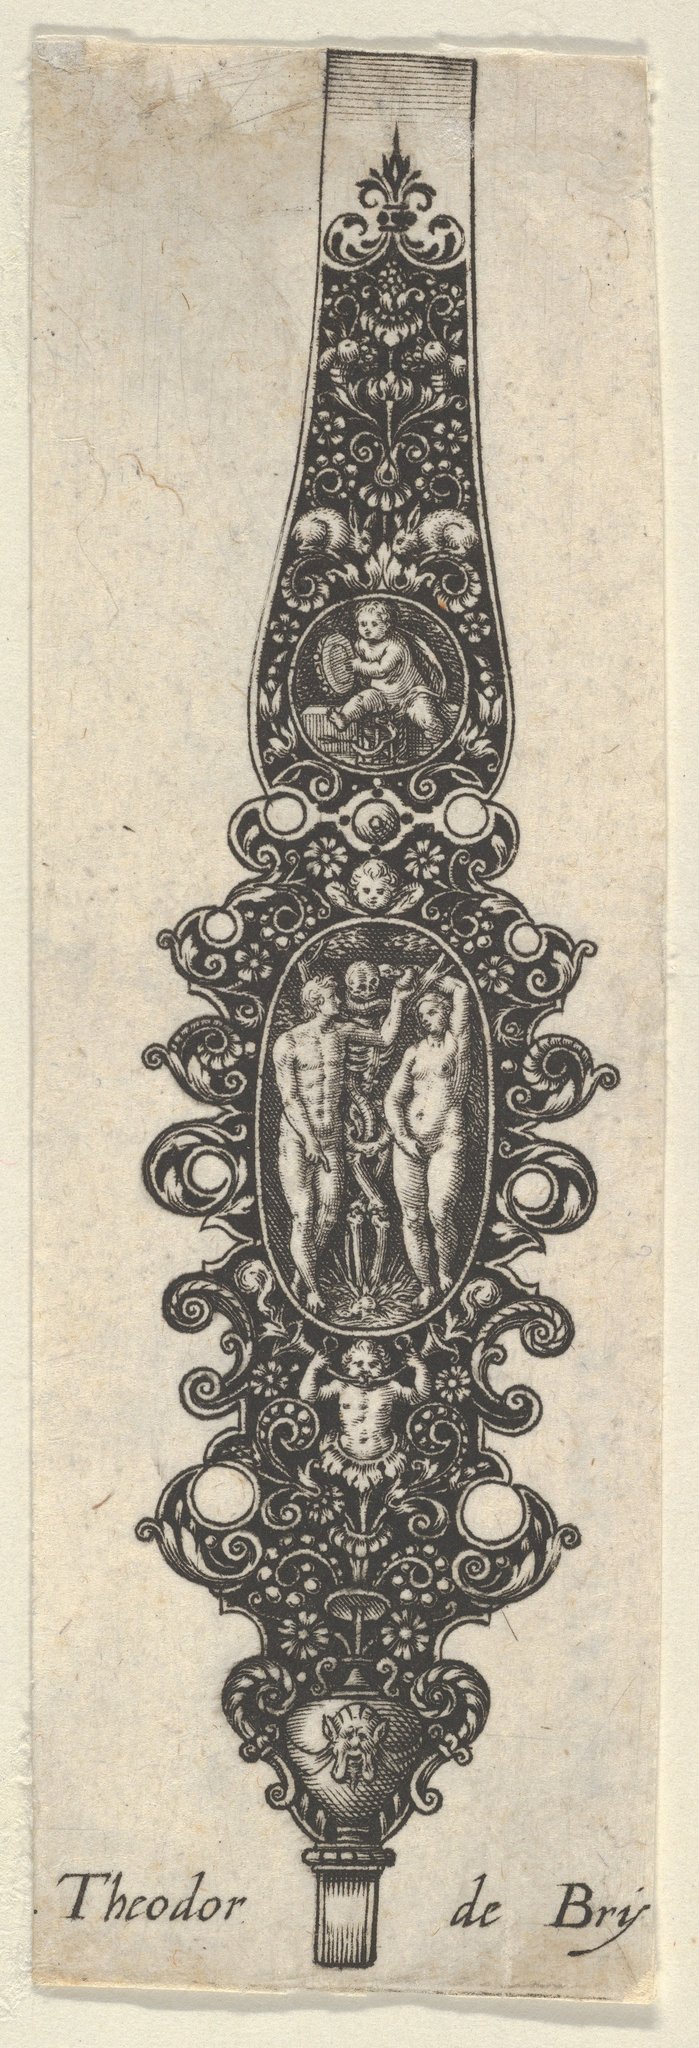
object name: print ornament architecture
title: Pendant Design with Adam and Eve, from Des Pendants de Cleffs pour les Femmes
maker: johann theodor de bry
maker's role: artist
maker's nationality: netherlandish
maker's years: 1561-1623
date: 1580-1600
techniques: embroidery, engraving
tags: ornament,adam,eve